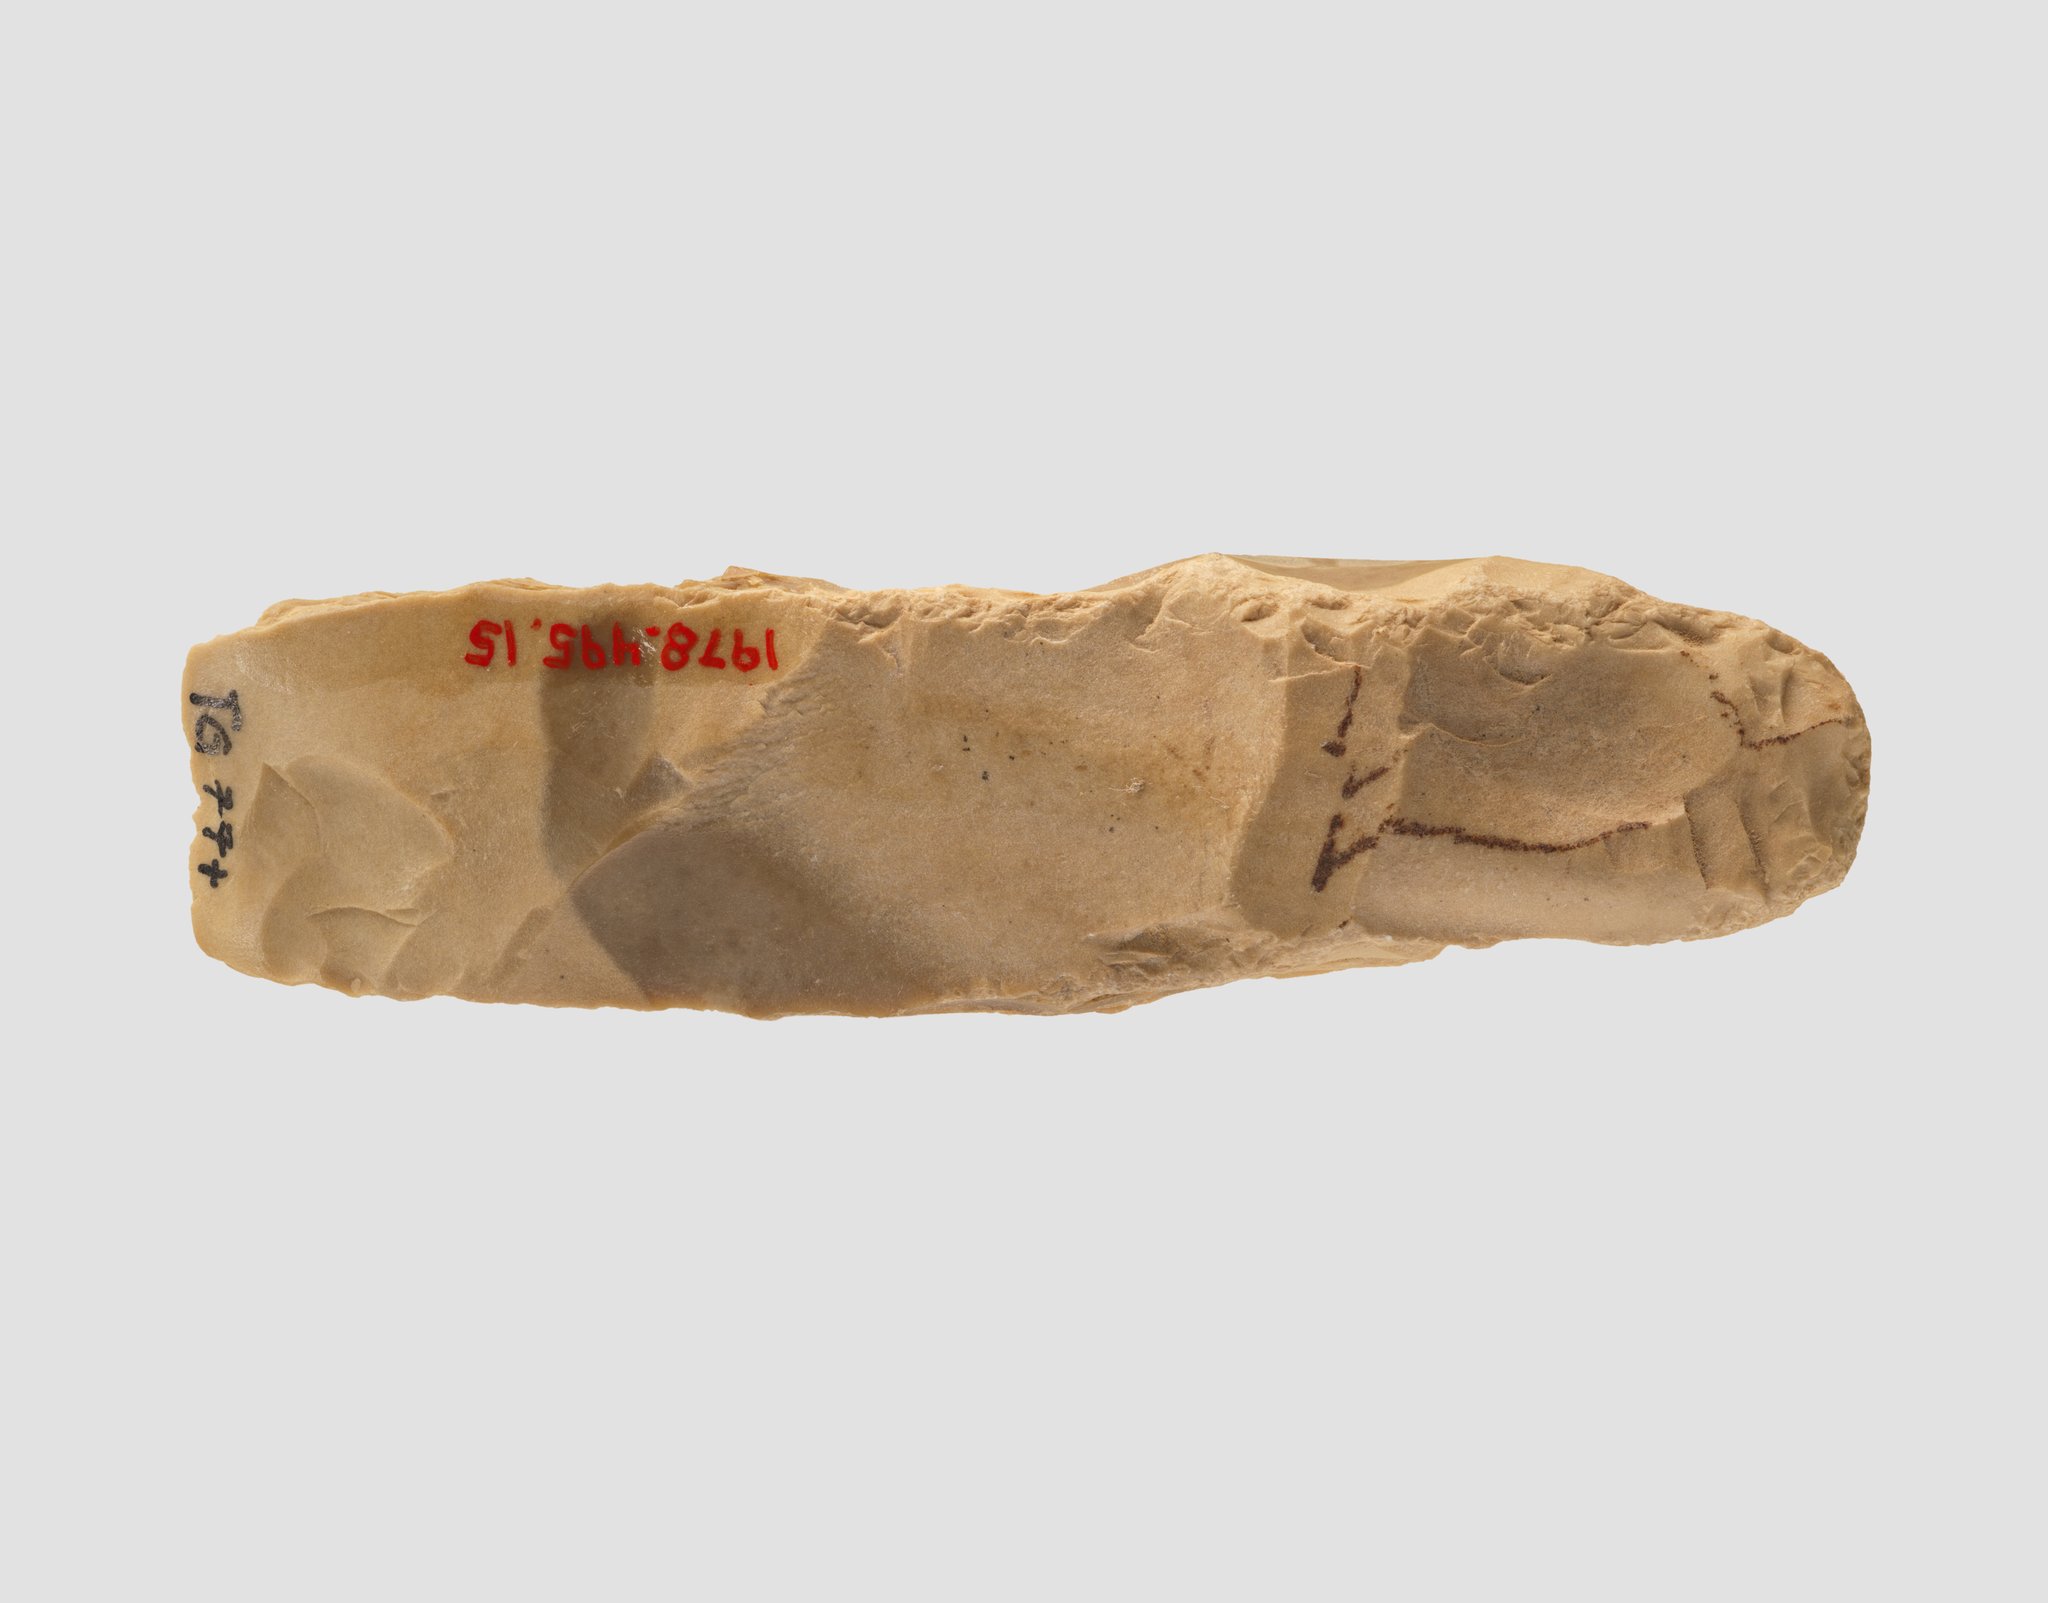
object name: chisel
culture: ghassulian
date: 4600-3600 BCE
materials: stone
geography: levant